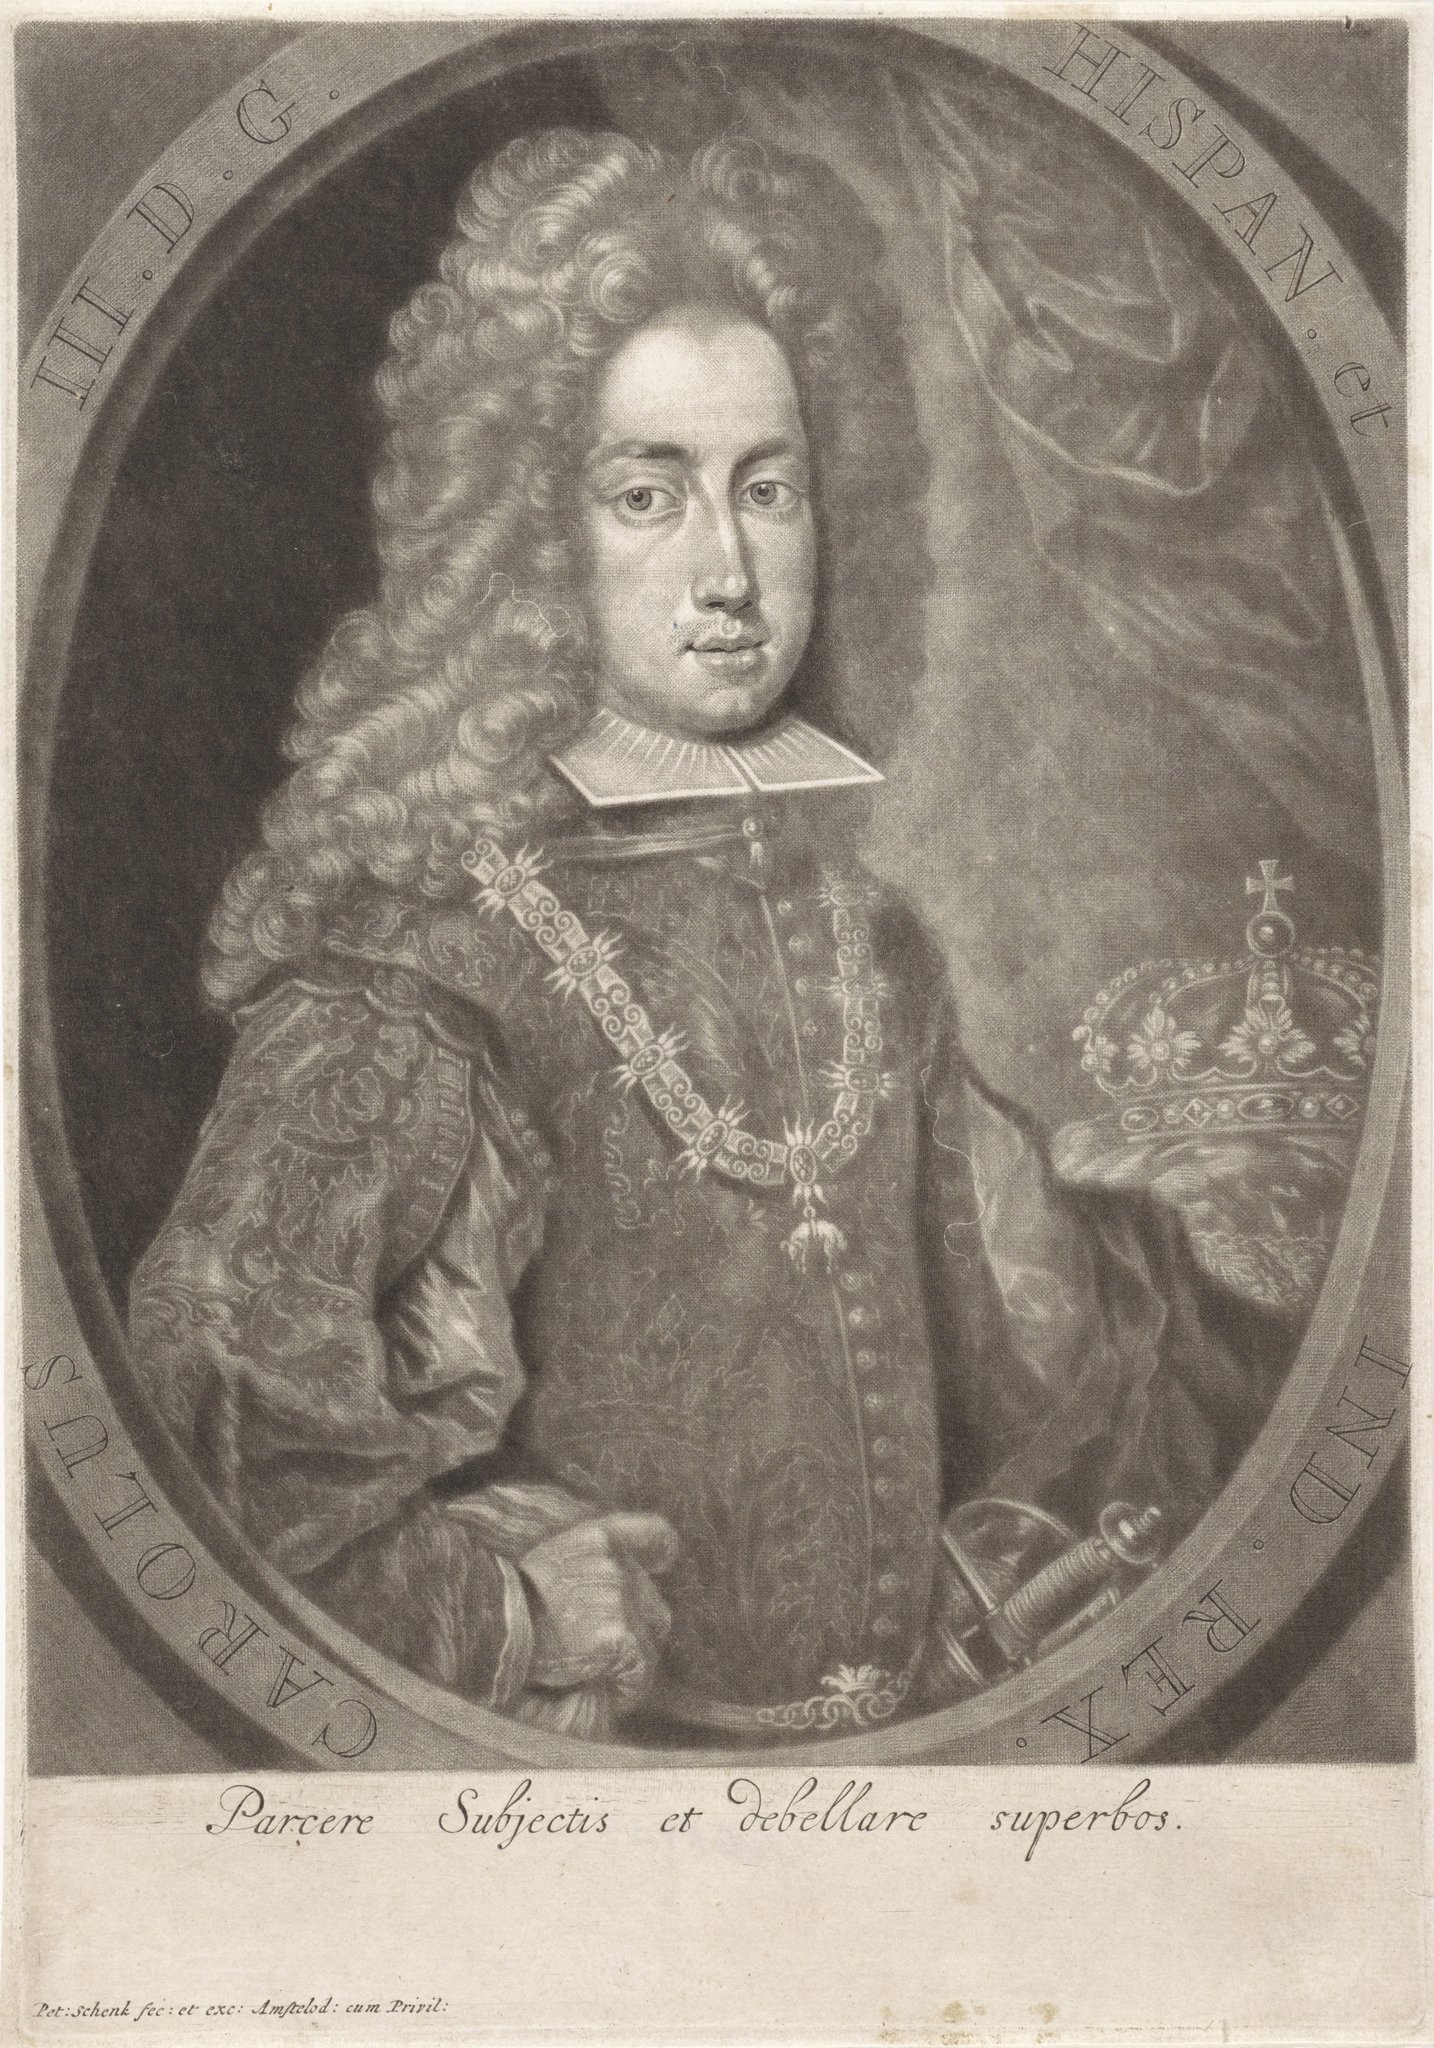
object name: print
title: Portret van keizer Karel VI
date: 1670-1711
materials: paper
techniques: engraving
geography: amsterdam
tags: vienna, charles vi (holy roman emperor), crown (symbol of sovereignty), knighthood order of the golden fleece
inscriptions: collector's mark: Lugt 2228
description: Portret van aartshertog Karel van Oostenrijk, die zichzelf tijdens de Spaanse Successieoorlog beschouwde en benoemde als koning Karel III van Spanje. Vanaf 1711 tot 1740 was hij keizer van het Heilige Roomse Rijk. Hij draag om de hals een ketting met het ordeteken van de Orde van het Gulden Vlies.